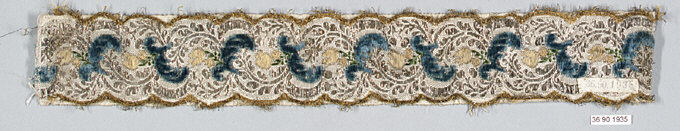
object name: galloon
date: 1701-1800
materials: metal thread, silk